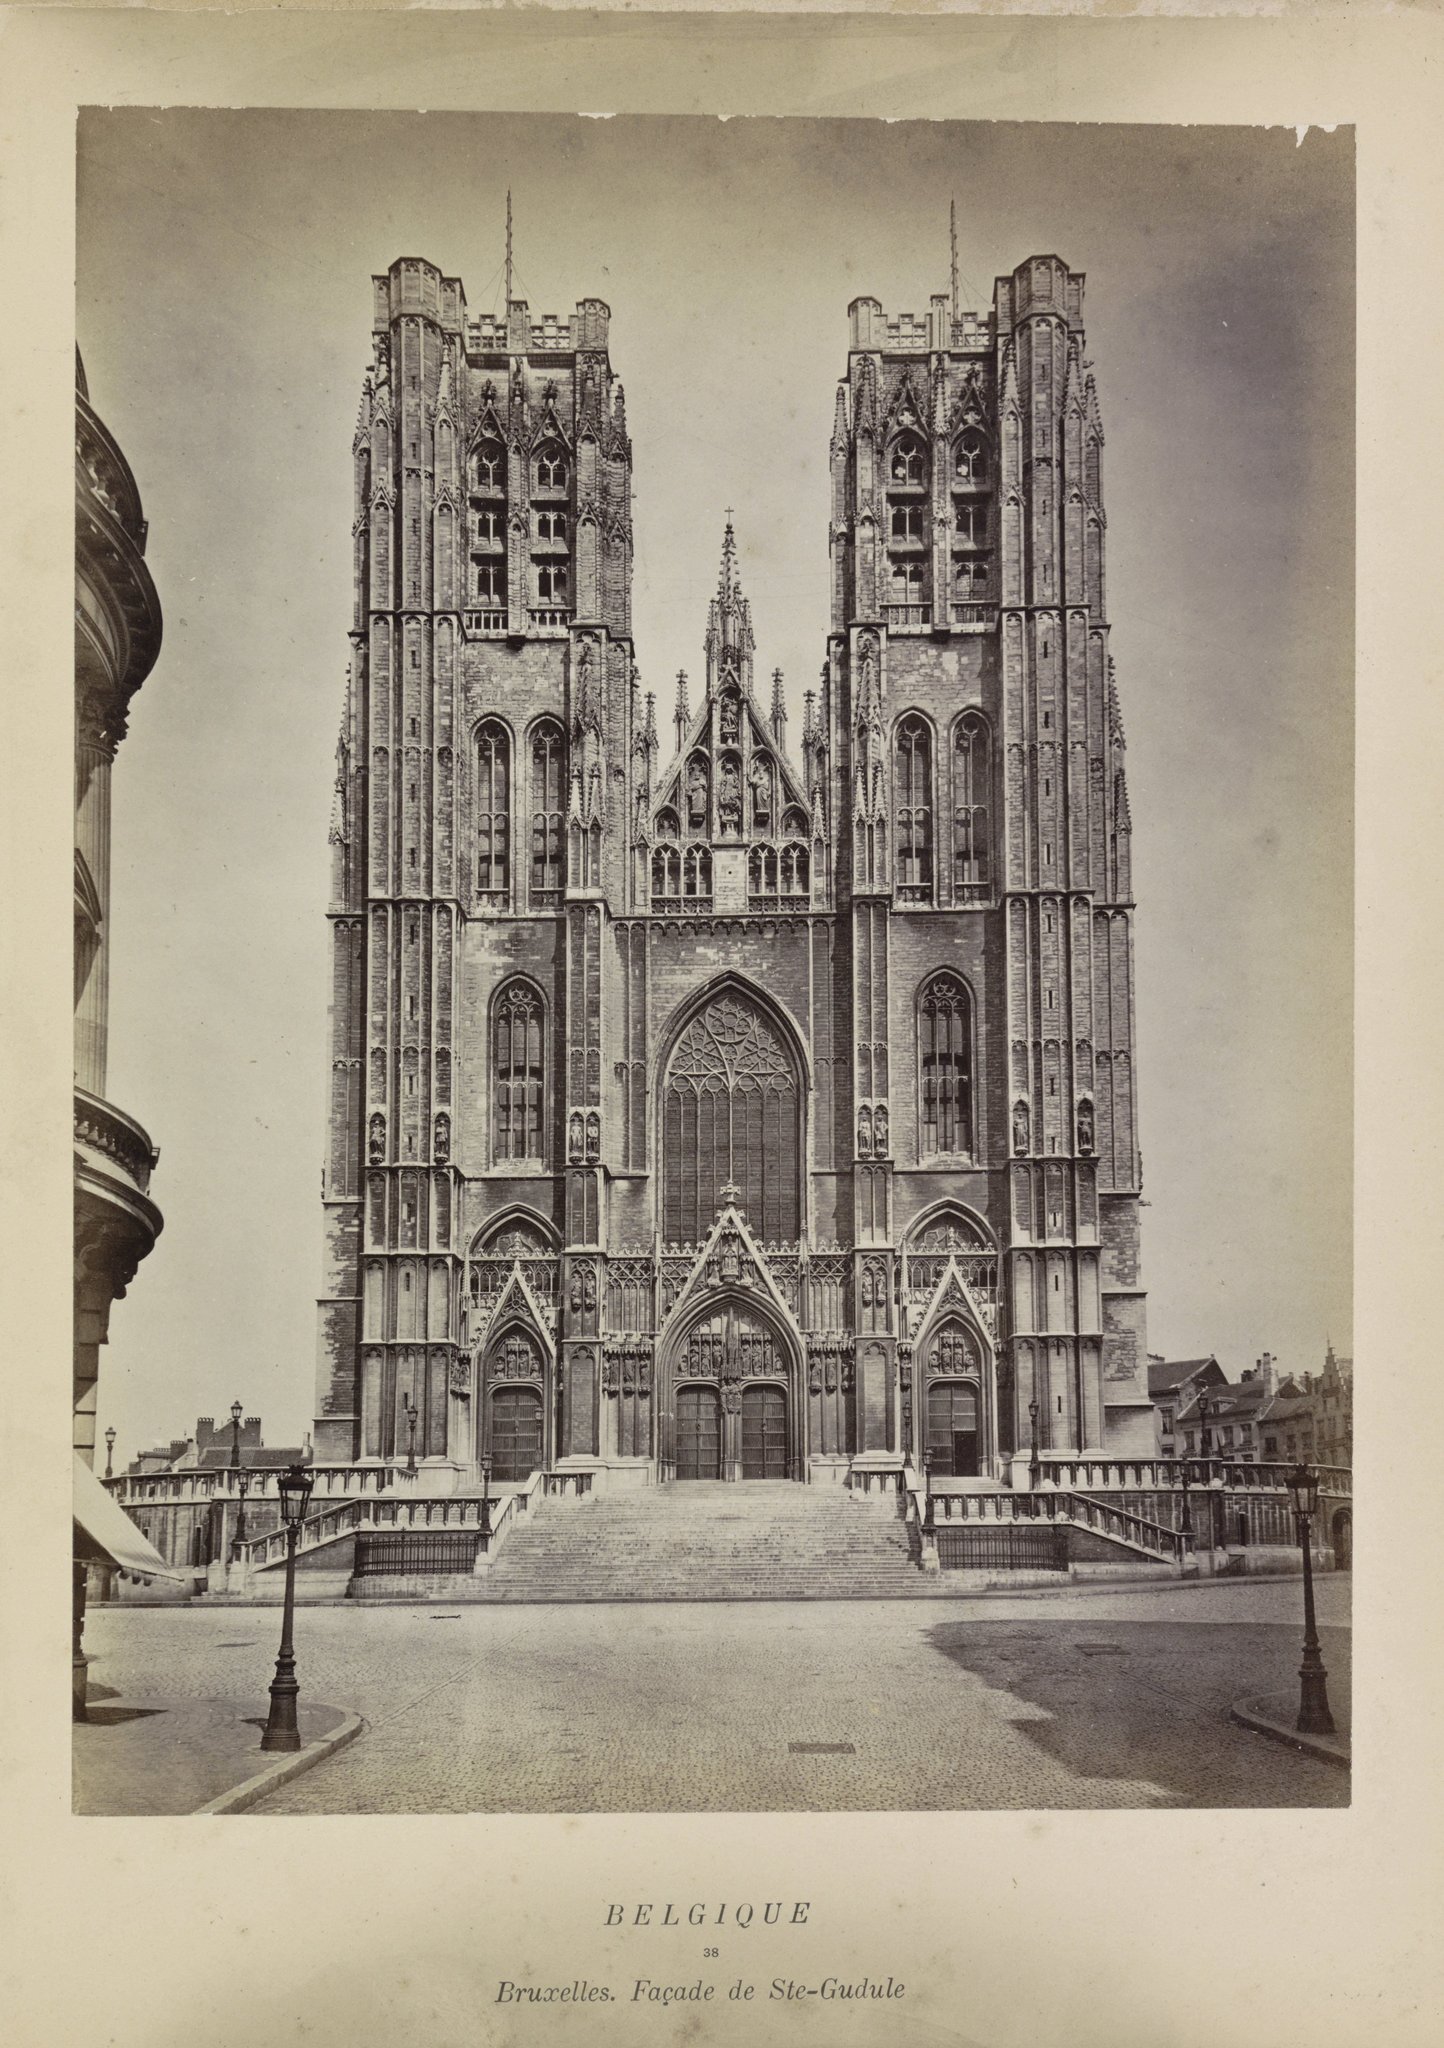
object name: photograph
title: Belgique / 38 / Bruxelles. Façade de Ste-Gudule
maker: Anonymous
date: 1885-1900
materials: paper, photographic support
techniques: albumen print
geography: france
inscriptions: caption: ‘Belgique / 38 / Bruxelles. Façade de Ste-Gudule’